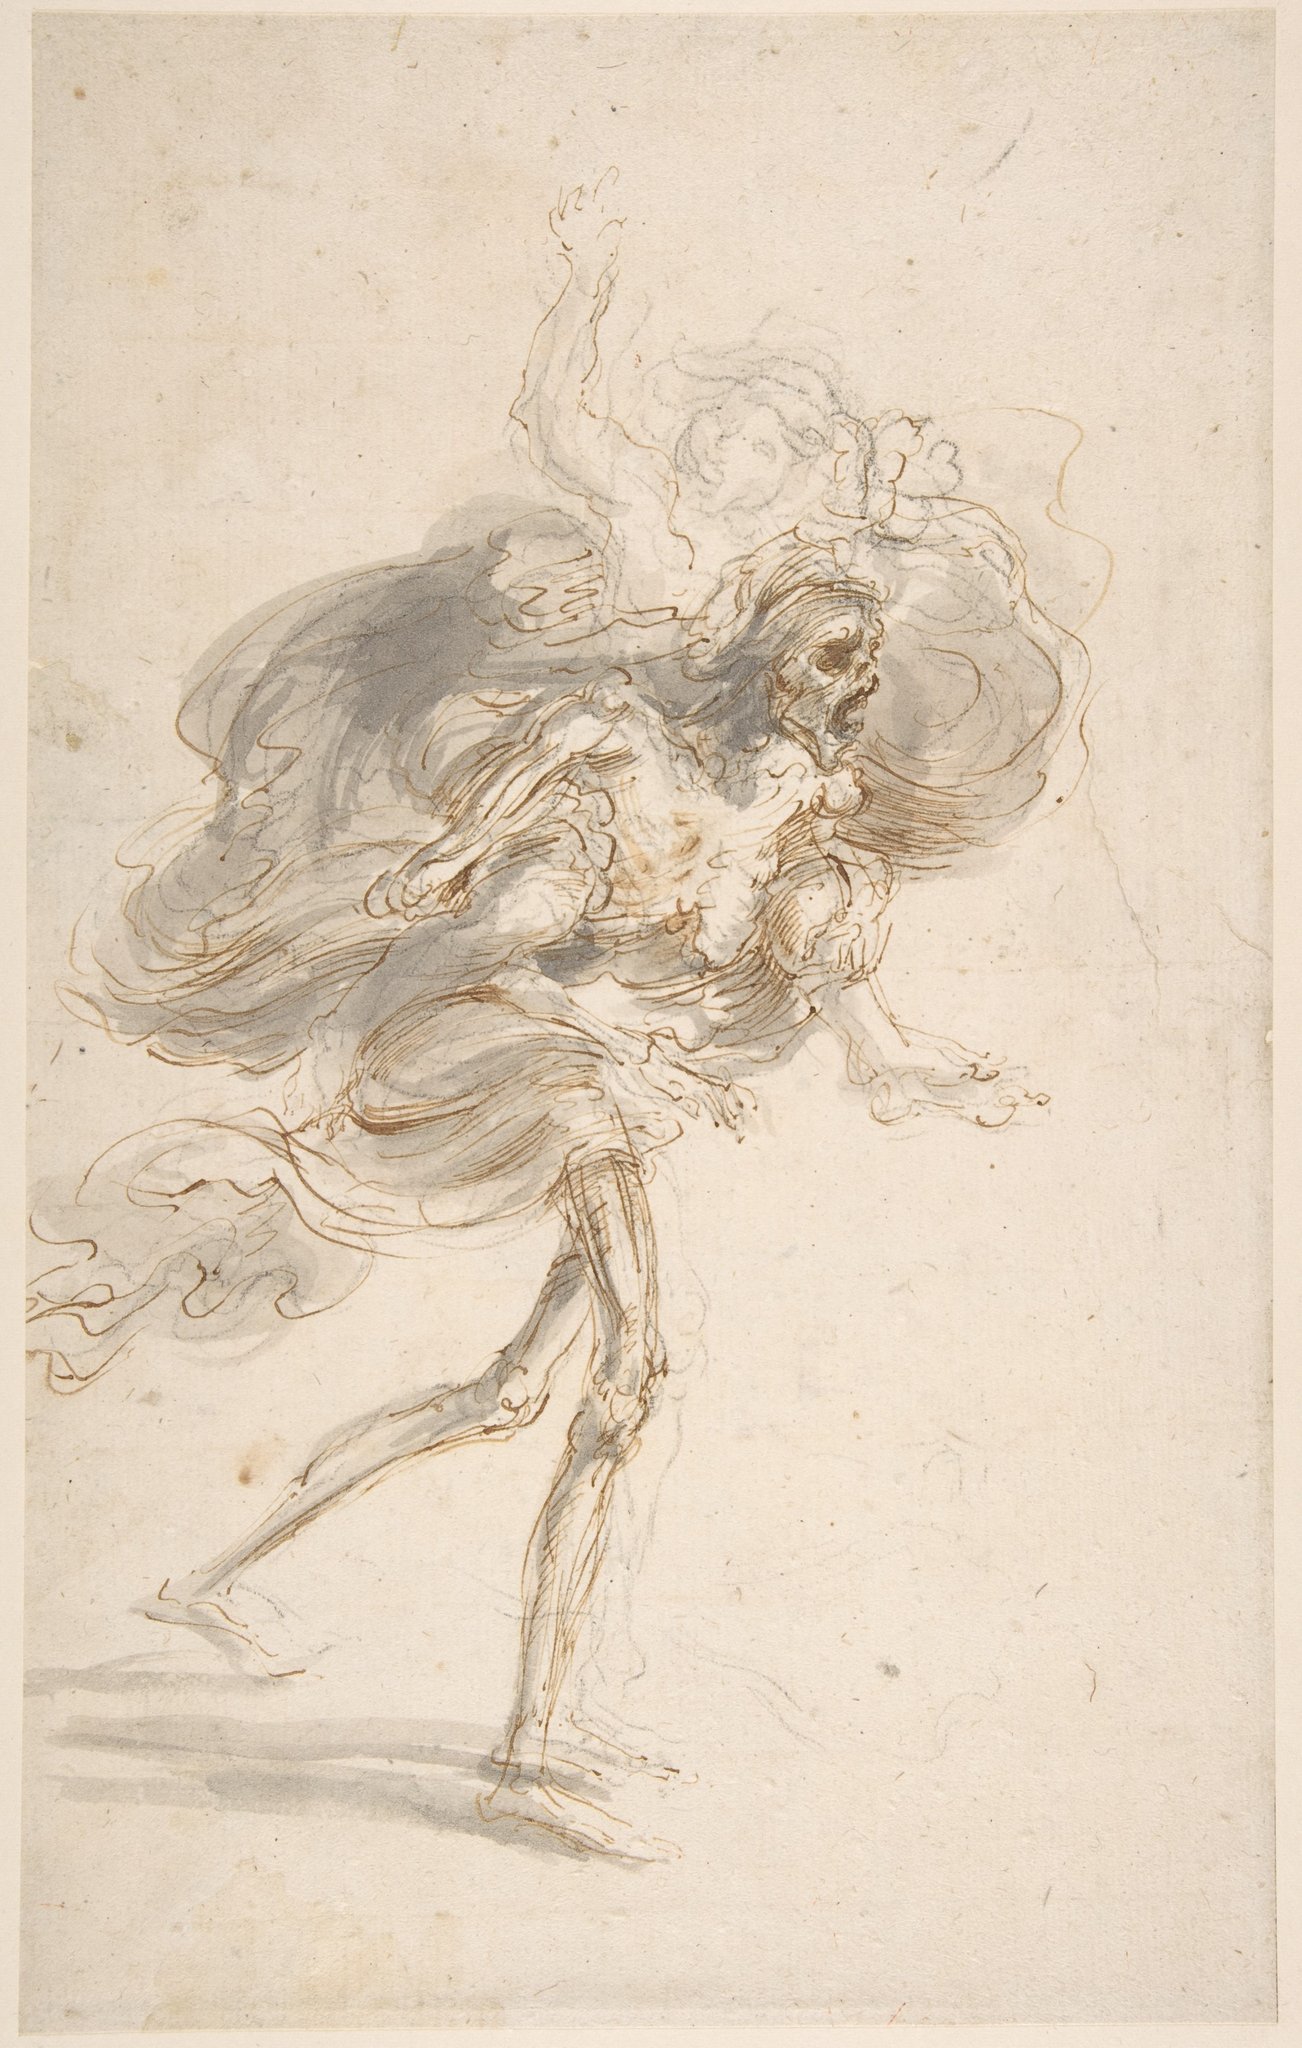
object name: drawing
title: Death Carrying a Child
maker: stefano della bella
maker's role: artist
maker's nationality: italian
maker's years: 1610-1664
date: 1610-1664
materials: chalk, ink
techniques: brush, pen, wash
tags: skeletons,children,death